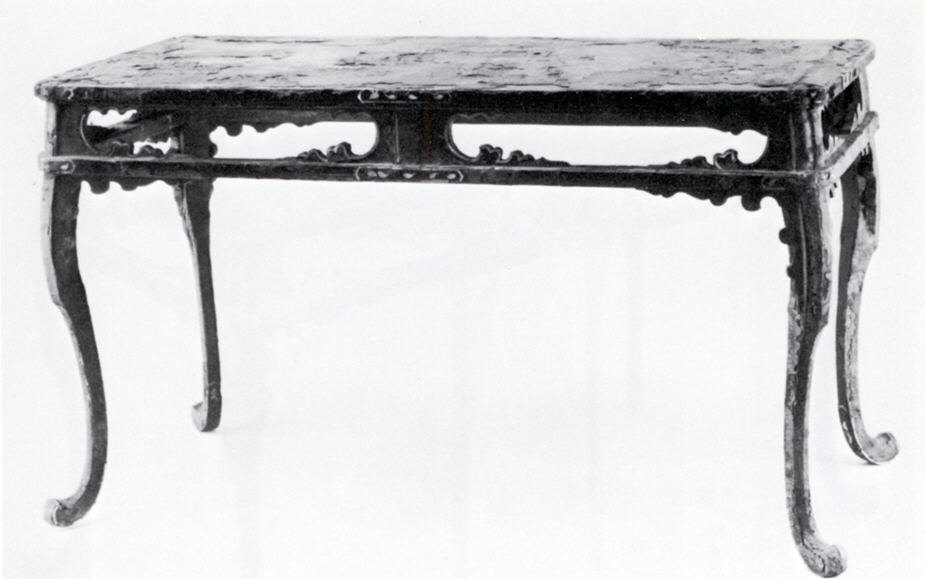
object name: altar table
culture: japanese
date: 1185-1333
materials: wood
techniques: carving, gilding, lacquer